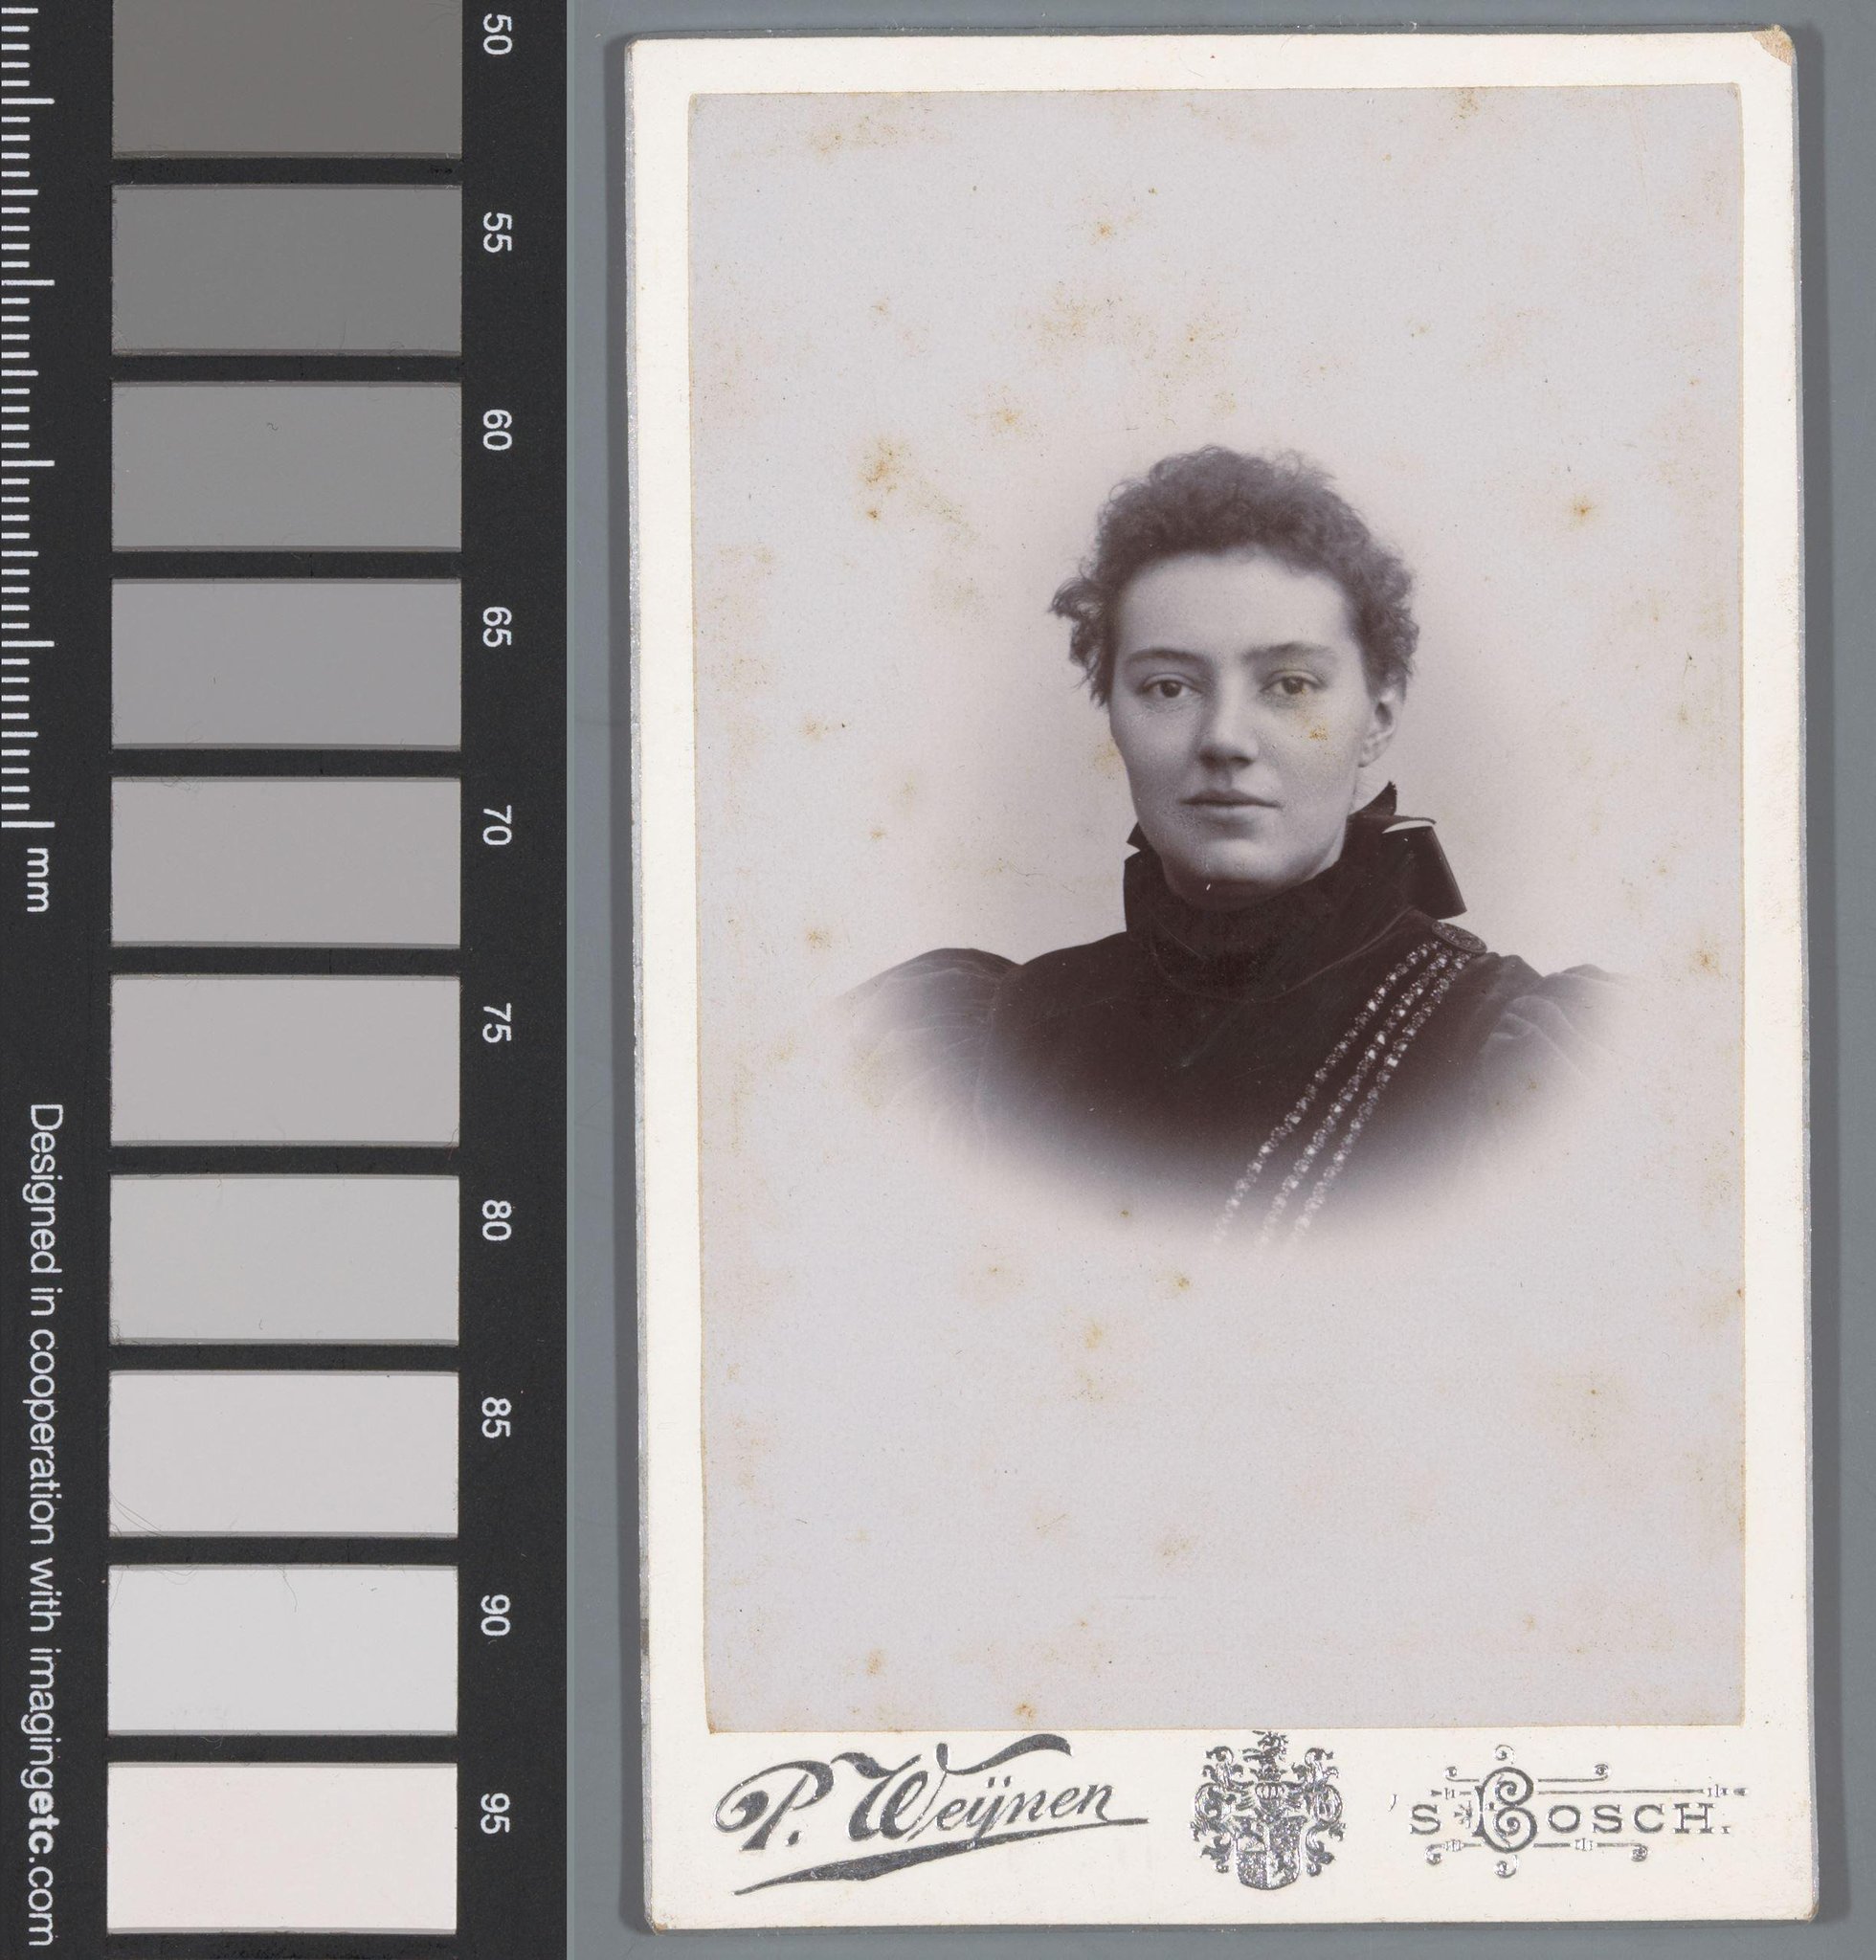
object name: photograph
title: Portret van een onbekende vrouw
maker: pierre weijnen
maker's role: fotograaf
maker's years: 1861-1933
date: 1885-1930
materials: paper, cardboard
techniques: collodion silver print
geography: den bosch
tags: adult woman, anonymous historical person portrayed, den bosch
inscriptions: inscription: ‘P. Weijnen 's Bosch’